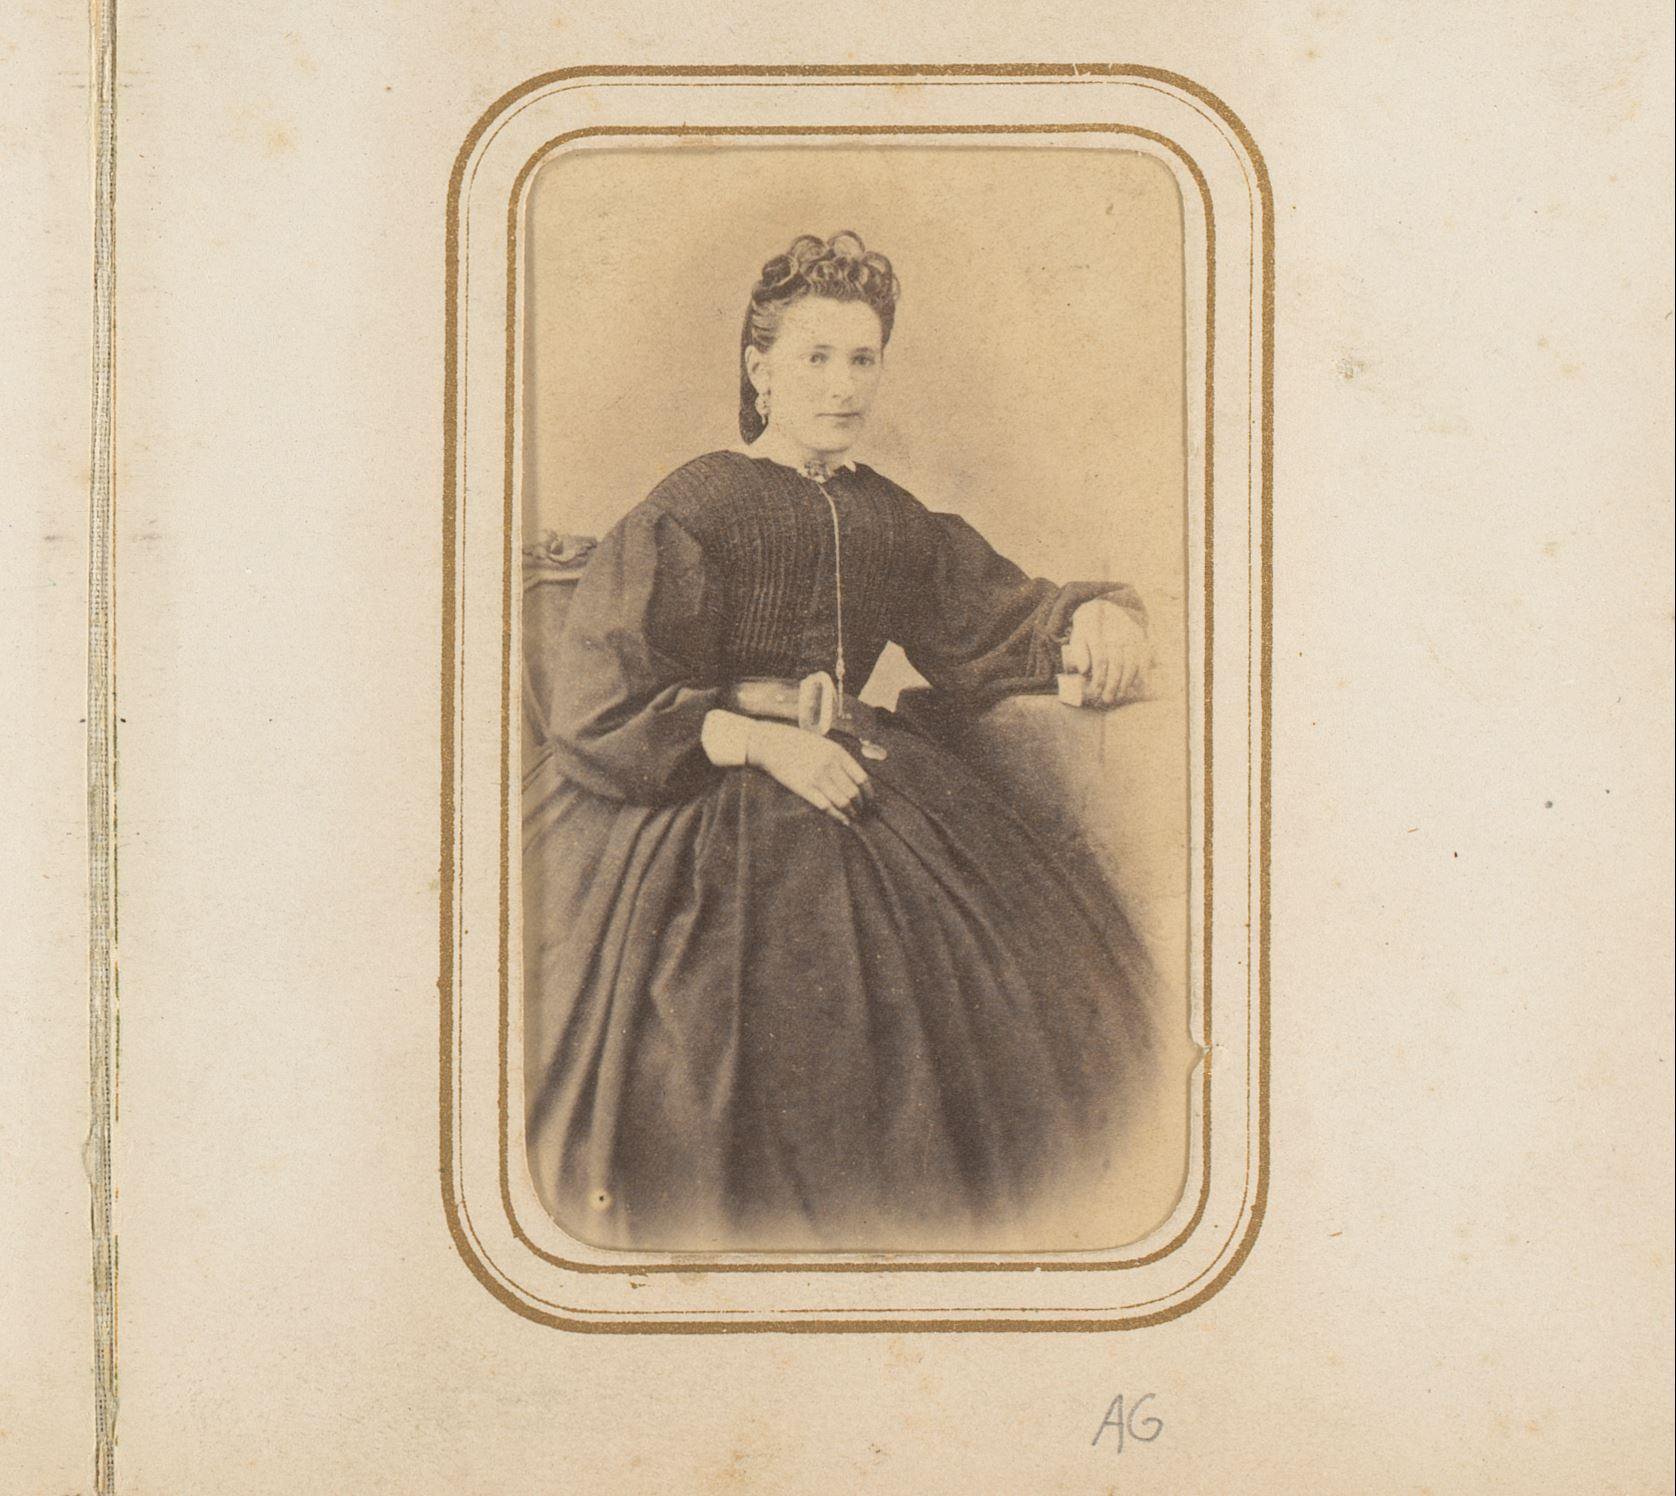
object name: album leaf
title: Portret van een zittende vrouw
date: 1866-1869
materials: cardboard, photographic support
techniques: albumen print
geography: rotterdam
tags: historical persons - bb - woman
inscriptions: inscription: ‘Nederlandsch-/ Photographische-/ Copieer-vereeniging/ J.M. Hessing & D. van Proijen/ Rotterdam’